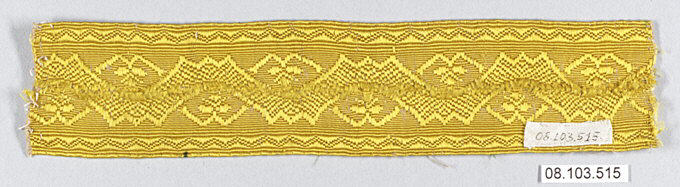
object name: galloon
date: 1701-1800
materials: cotton, silk